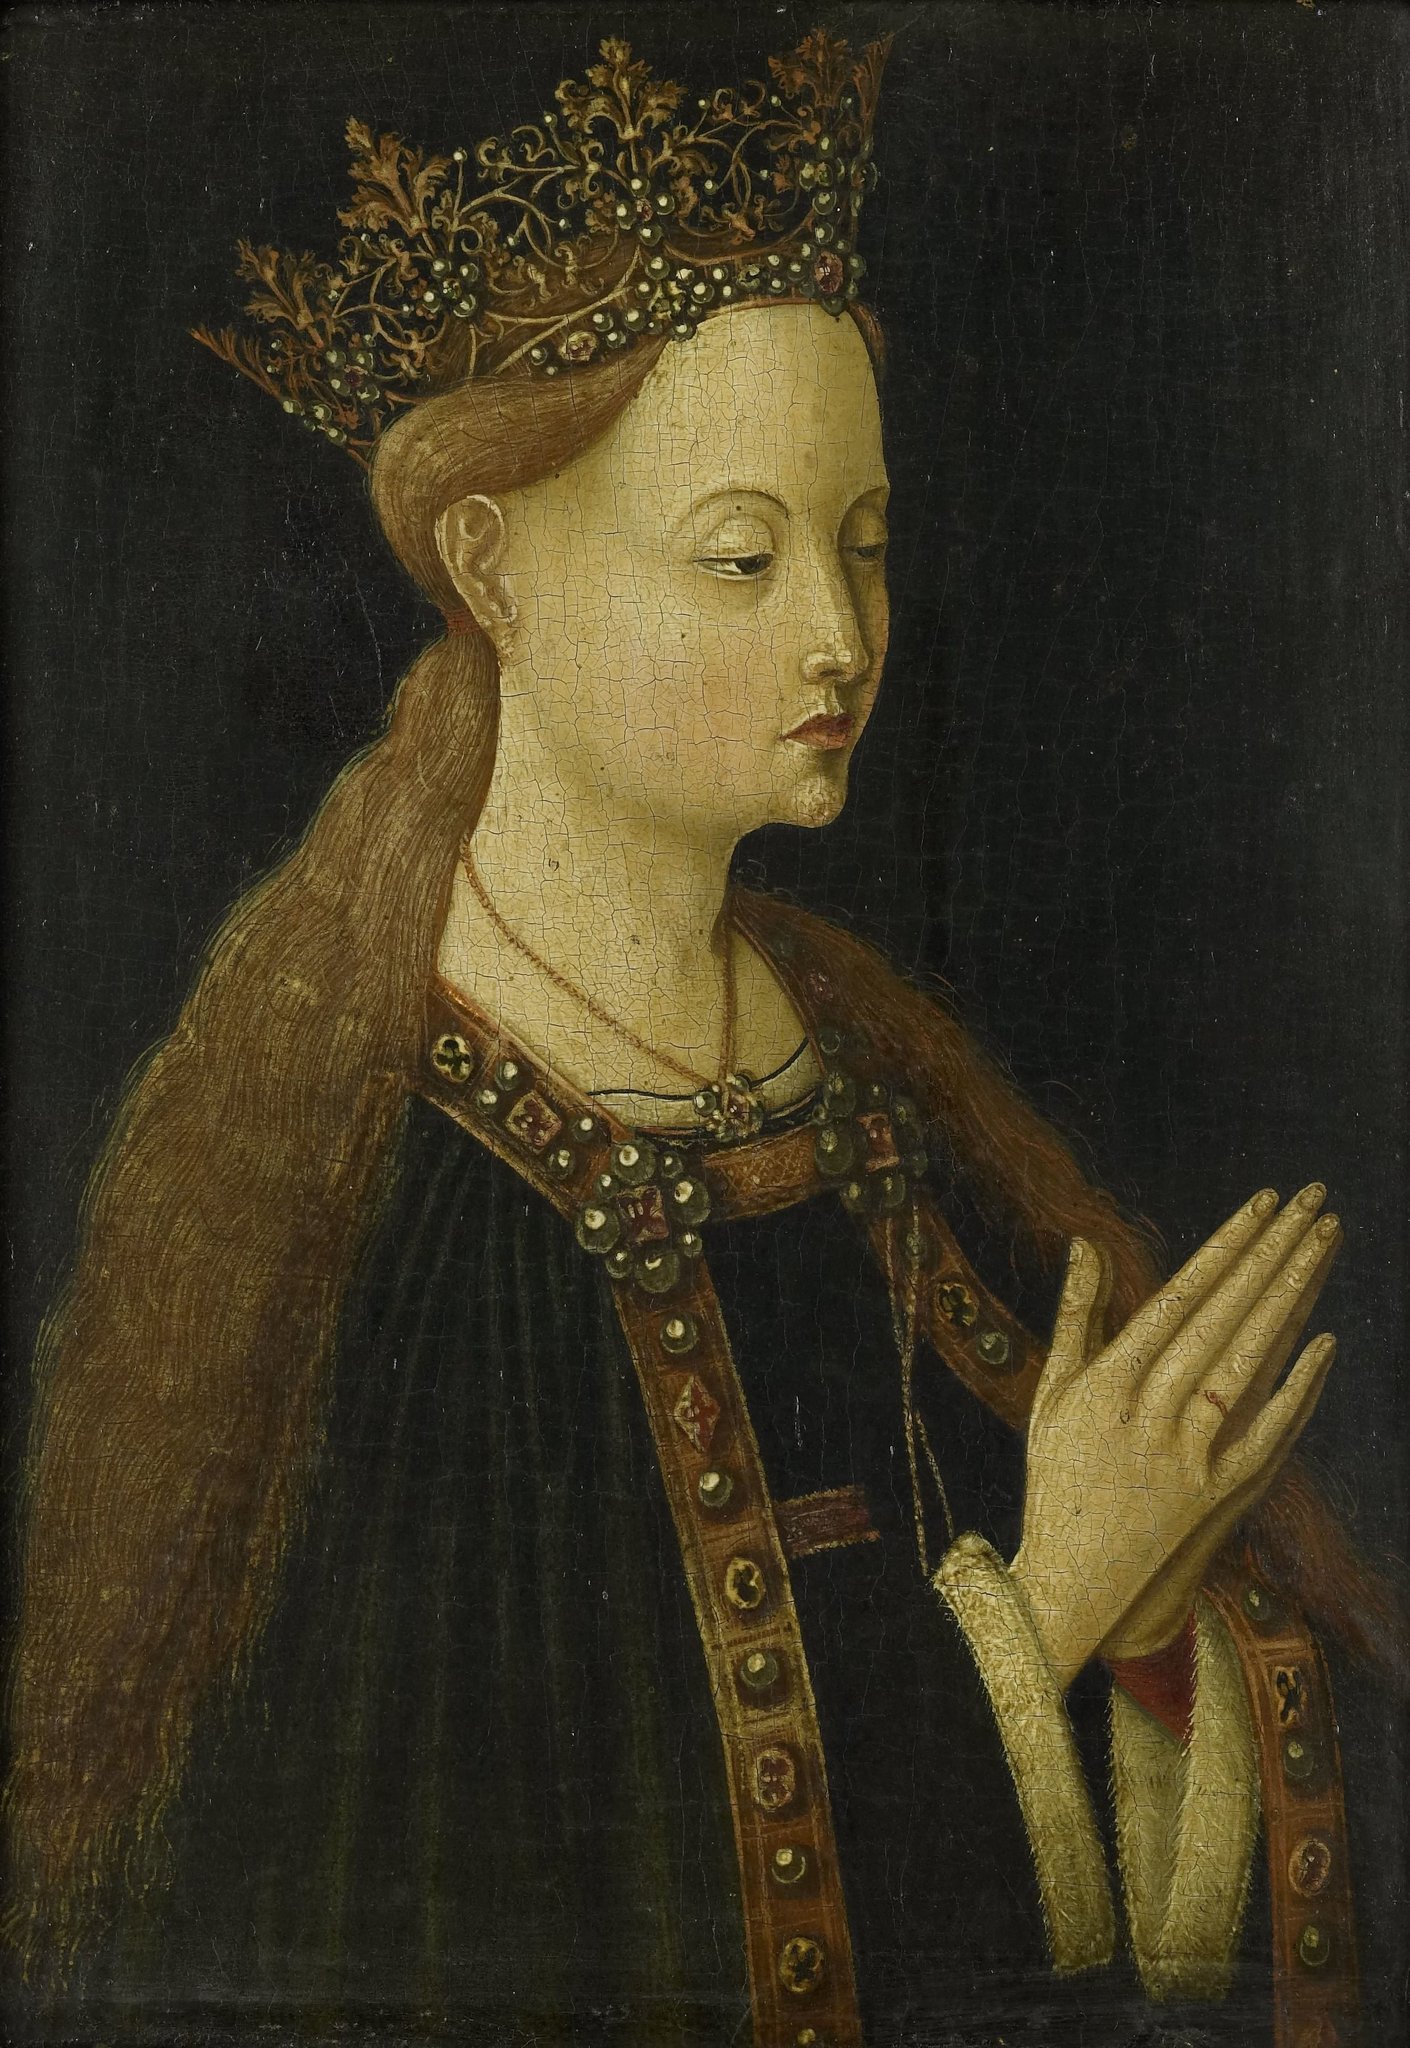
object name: painting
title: The Virgin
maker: Anonymous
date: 1500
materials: oil, panel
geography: southern germany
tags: mary (without the christ-child)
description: Halffiguur van Maria, gekroond, met gevouwen handen naar rechts. Pendant van SK-A-496.